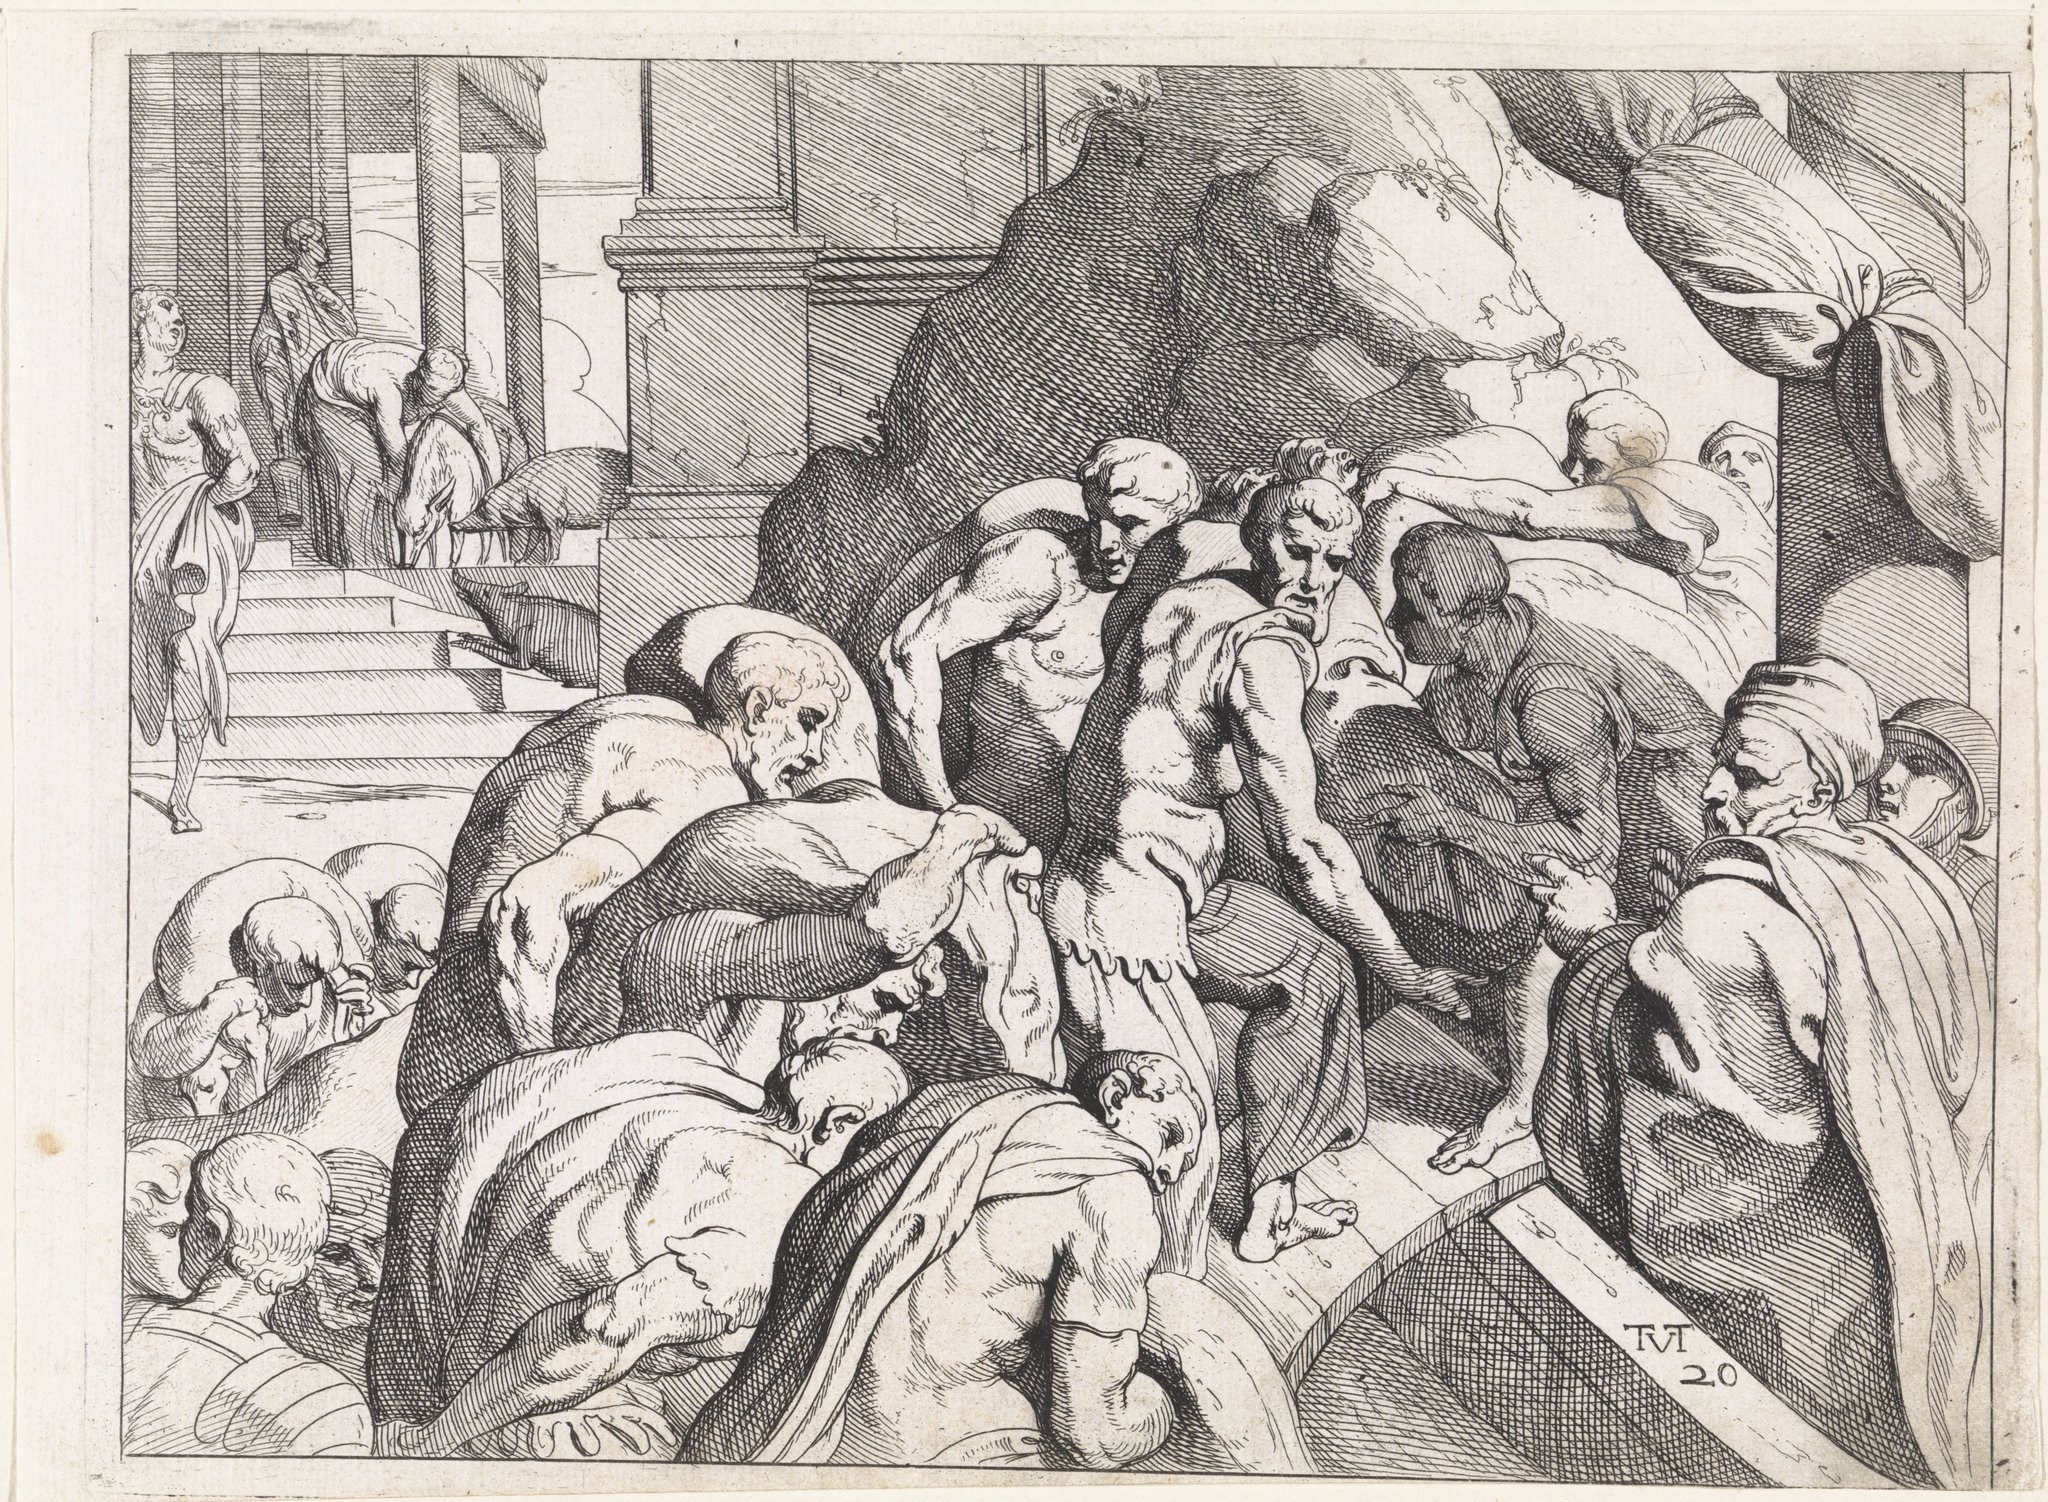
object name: print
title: De werken van Odysseus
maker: theodoor van thulden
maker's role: draughtsman, painter, print maker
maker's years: 1606-1669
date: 1632-1633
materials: paper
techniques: engraving, etching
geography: paris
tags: ulysses departs from the island of circe and passes through a series of dangers, which circe had warned him about (homer, odyssey xii)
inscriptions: collector's mark: Lugt 2228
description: Odysseus en zijn mannen gaan aan boord van hun schip en verlaten Circe. De mannen nemen dieren en voorraad mee.